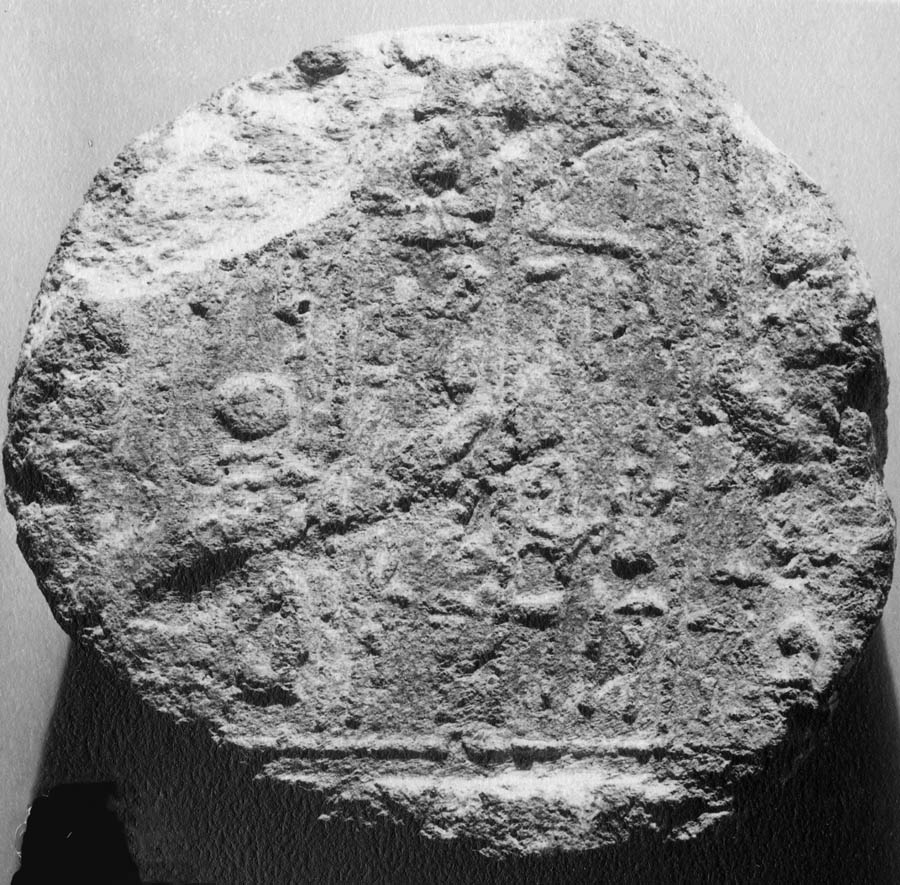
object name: cone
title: Funerary Cone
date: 1550-1295 BCE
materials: pottery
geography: egypt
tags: hieroglyphs